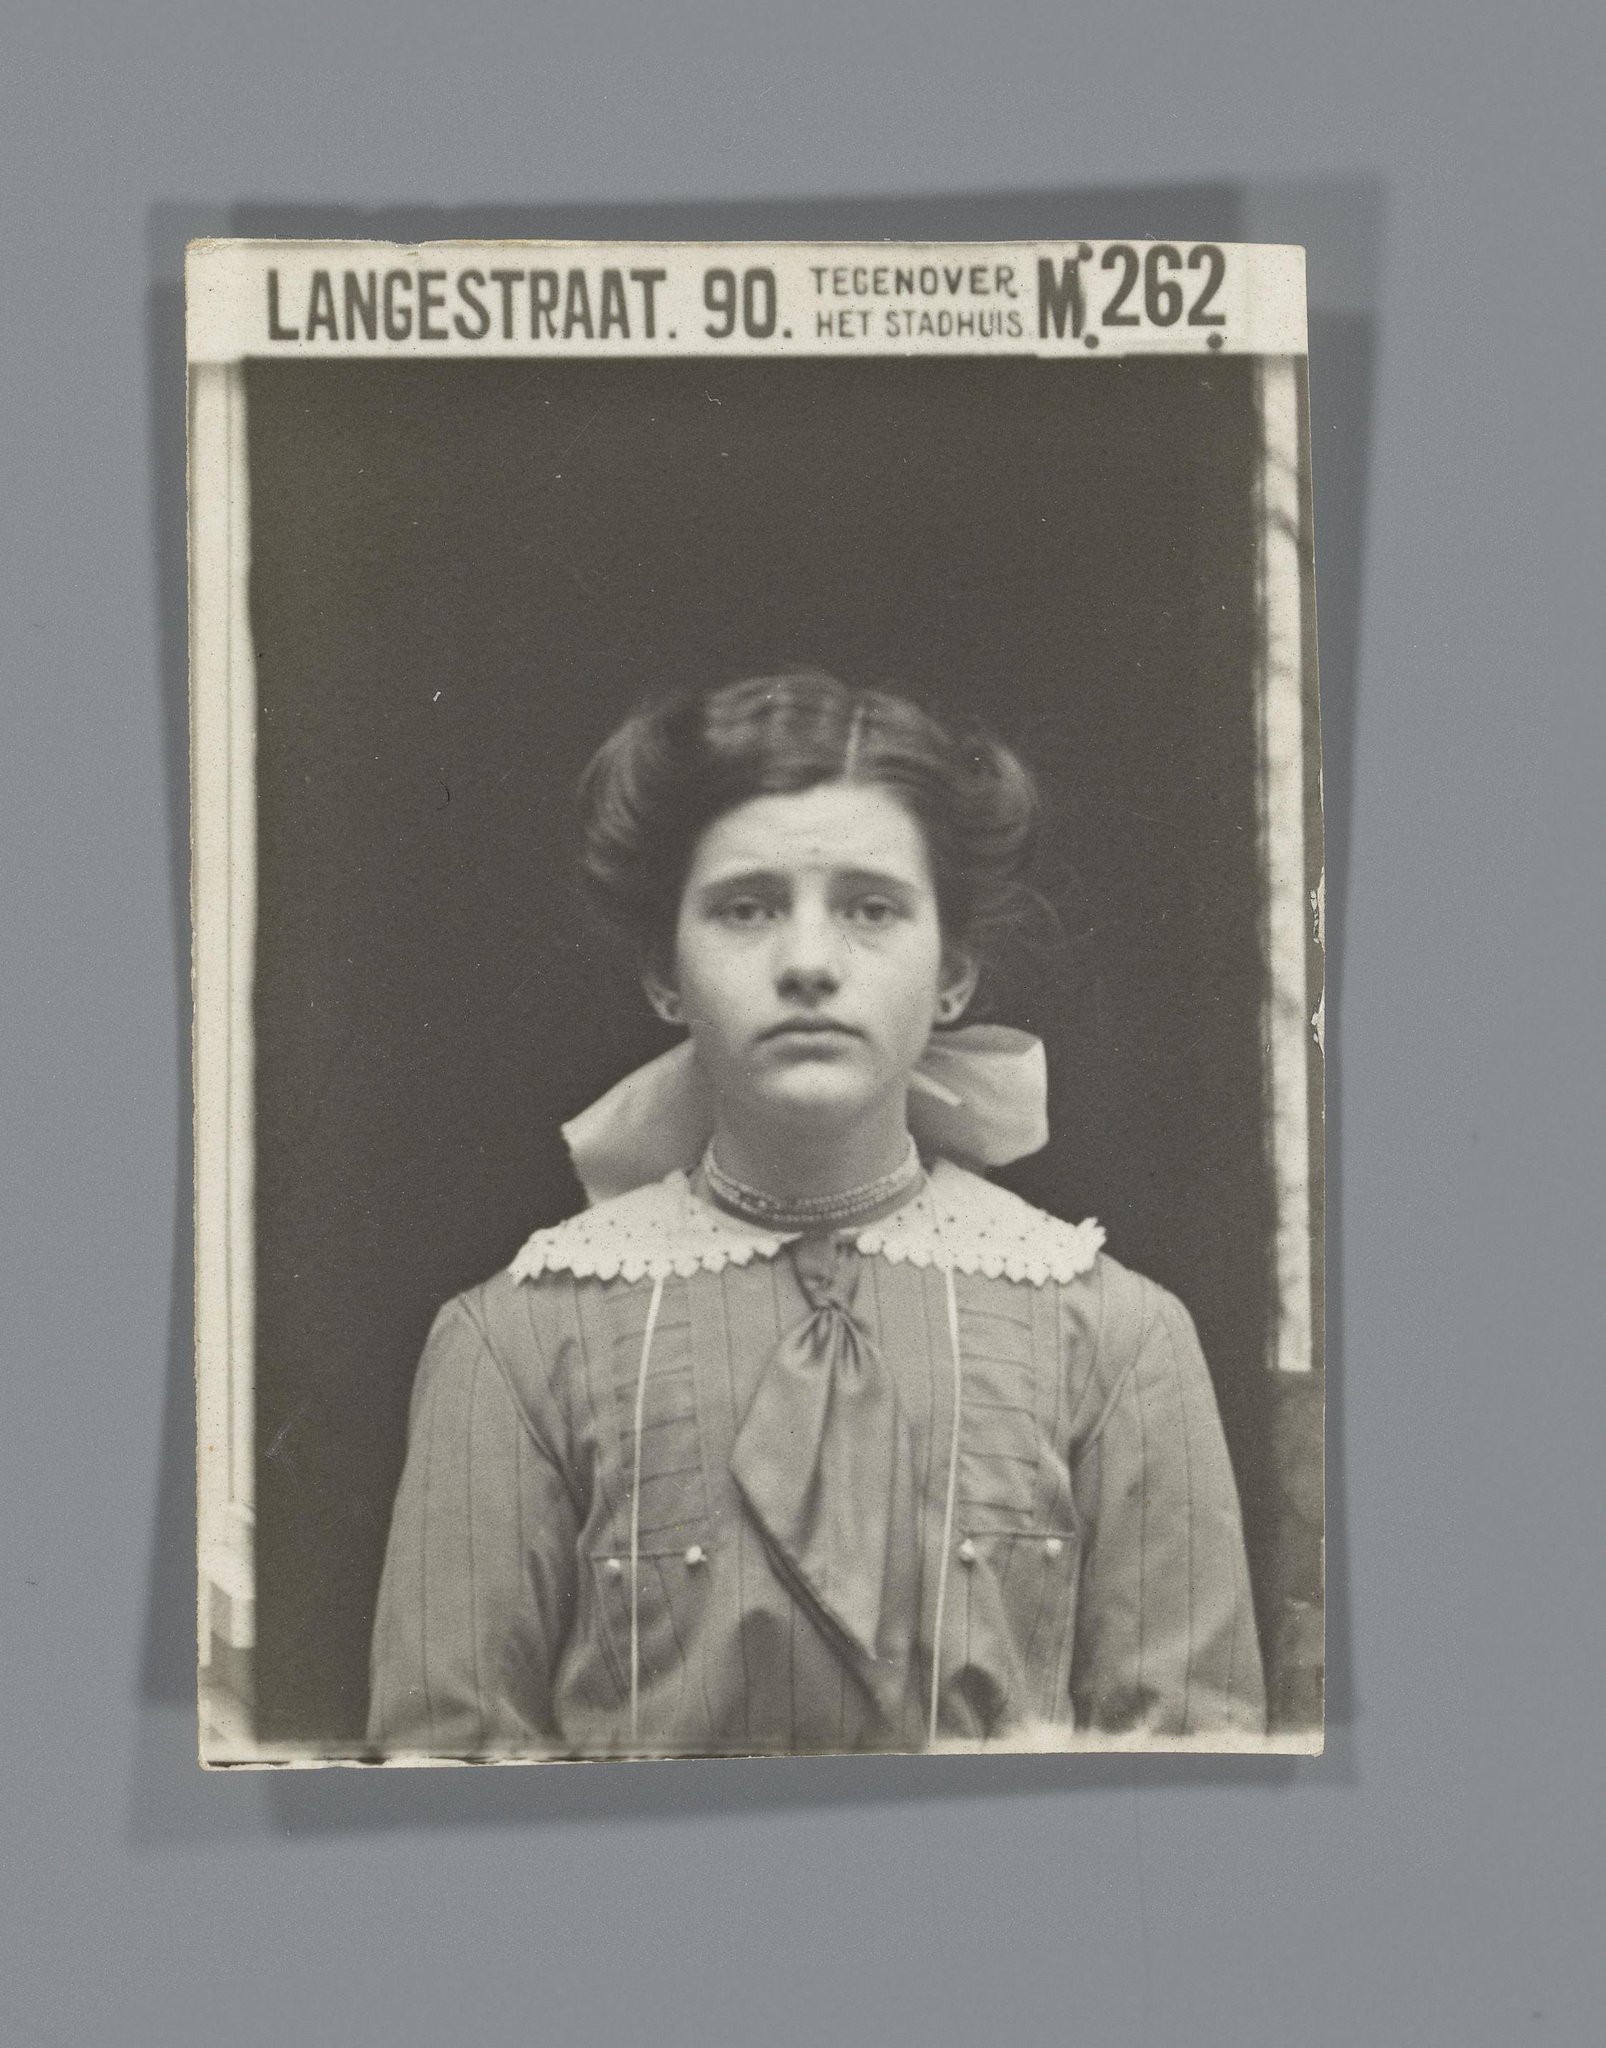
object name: snapshot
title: Rapid photographs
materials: photographic support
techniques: gelatin silver print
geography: alkmaar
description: Between 1912 and 1930, anyone could have their portrait taken at the many so-called rapid photography studios in the shopping streets of mainly (medium) large-size European cities. As if on an assembly line, the youngest clerk shot the photographs with a special camera and in artificial light and developed them. Later in the day, the customer collected a sheet with 12 portrait photos for 25 cents. This form of photographic mass production gave rise to a fascinating tableau of boys, girls, men and women not previously seen in photographs; candid and informal. There were at least 150 quick-photo studios, from Alkmaar to Zutphen. Many called themselves ‘American,’ mistakenly as it turns out because hardly any examples from that country have been found.